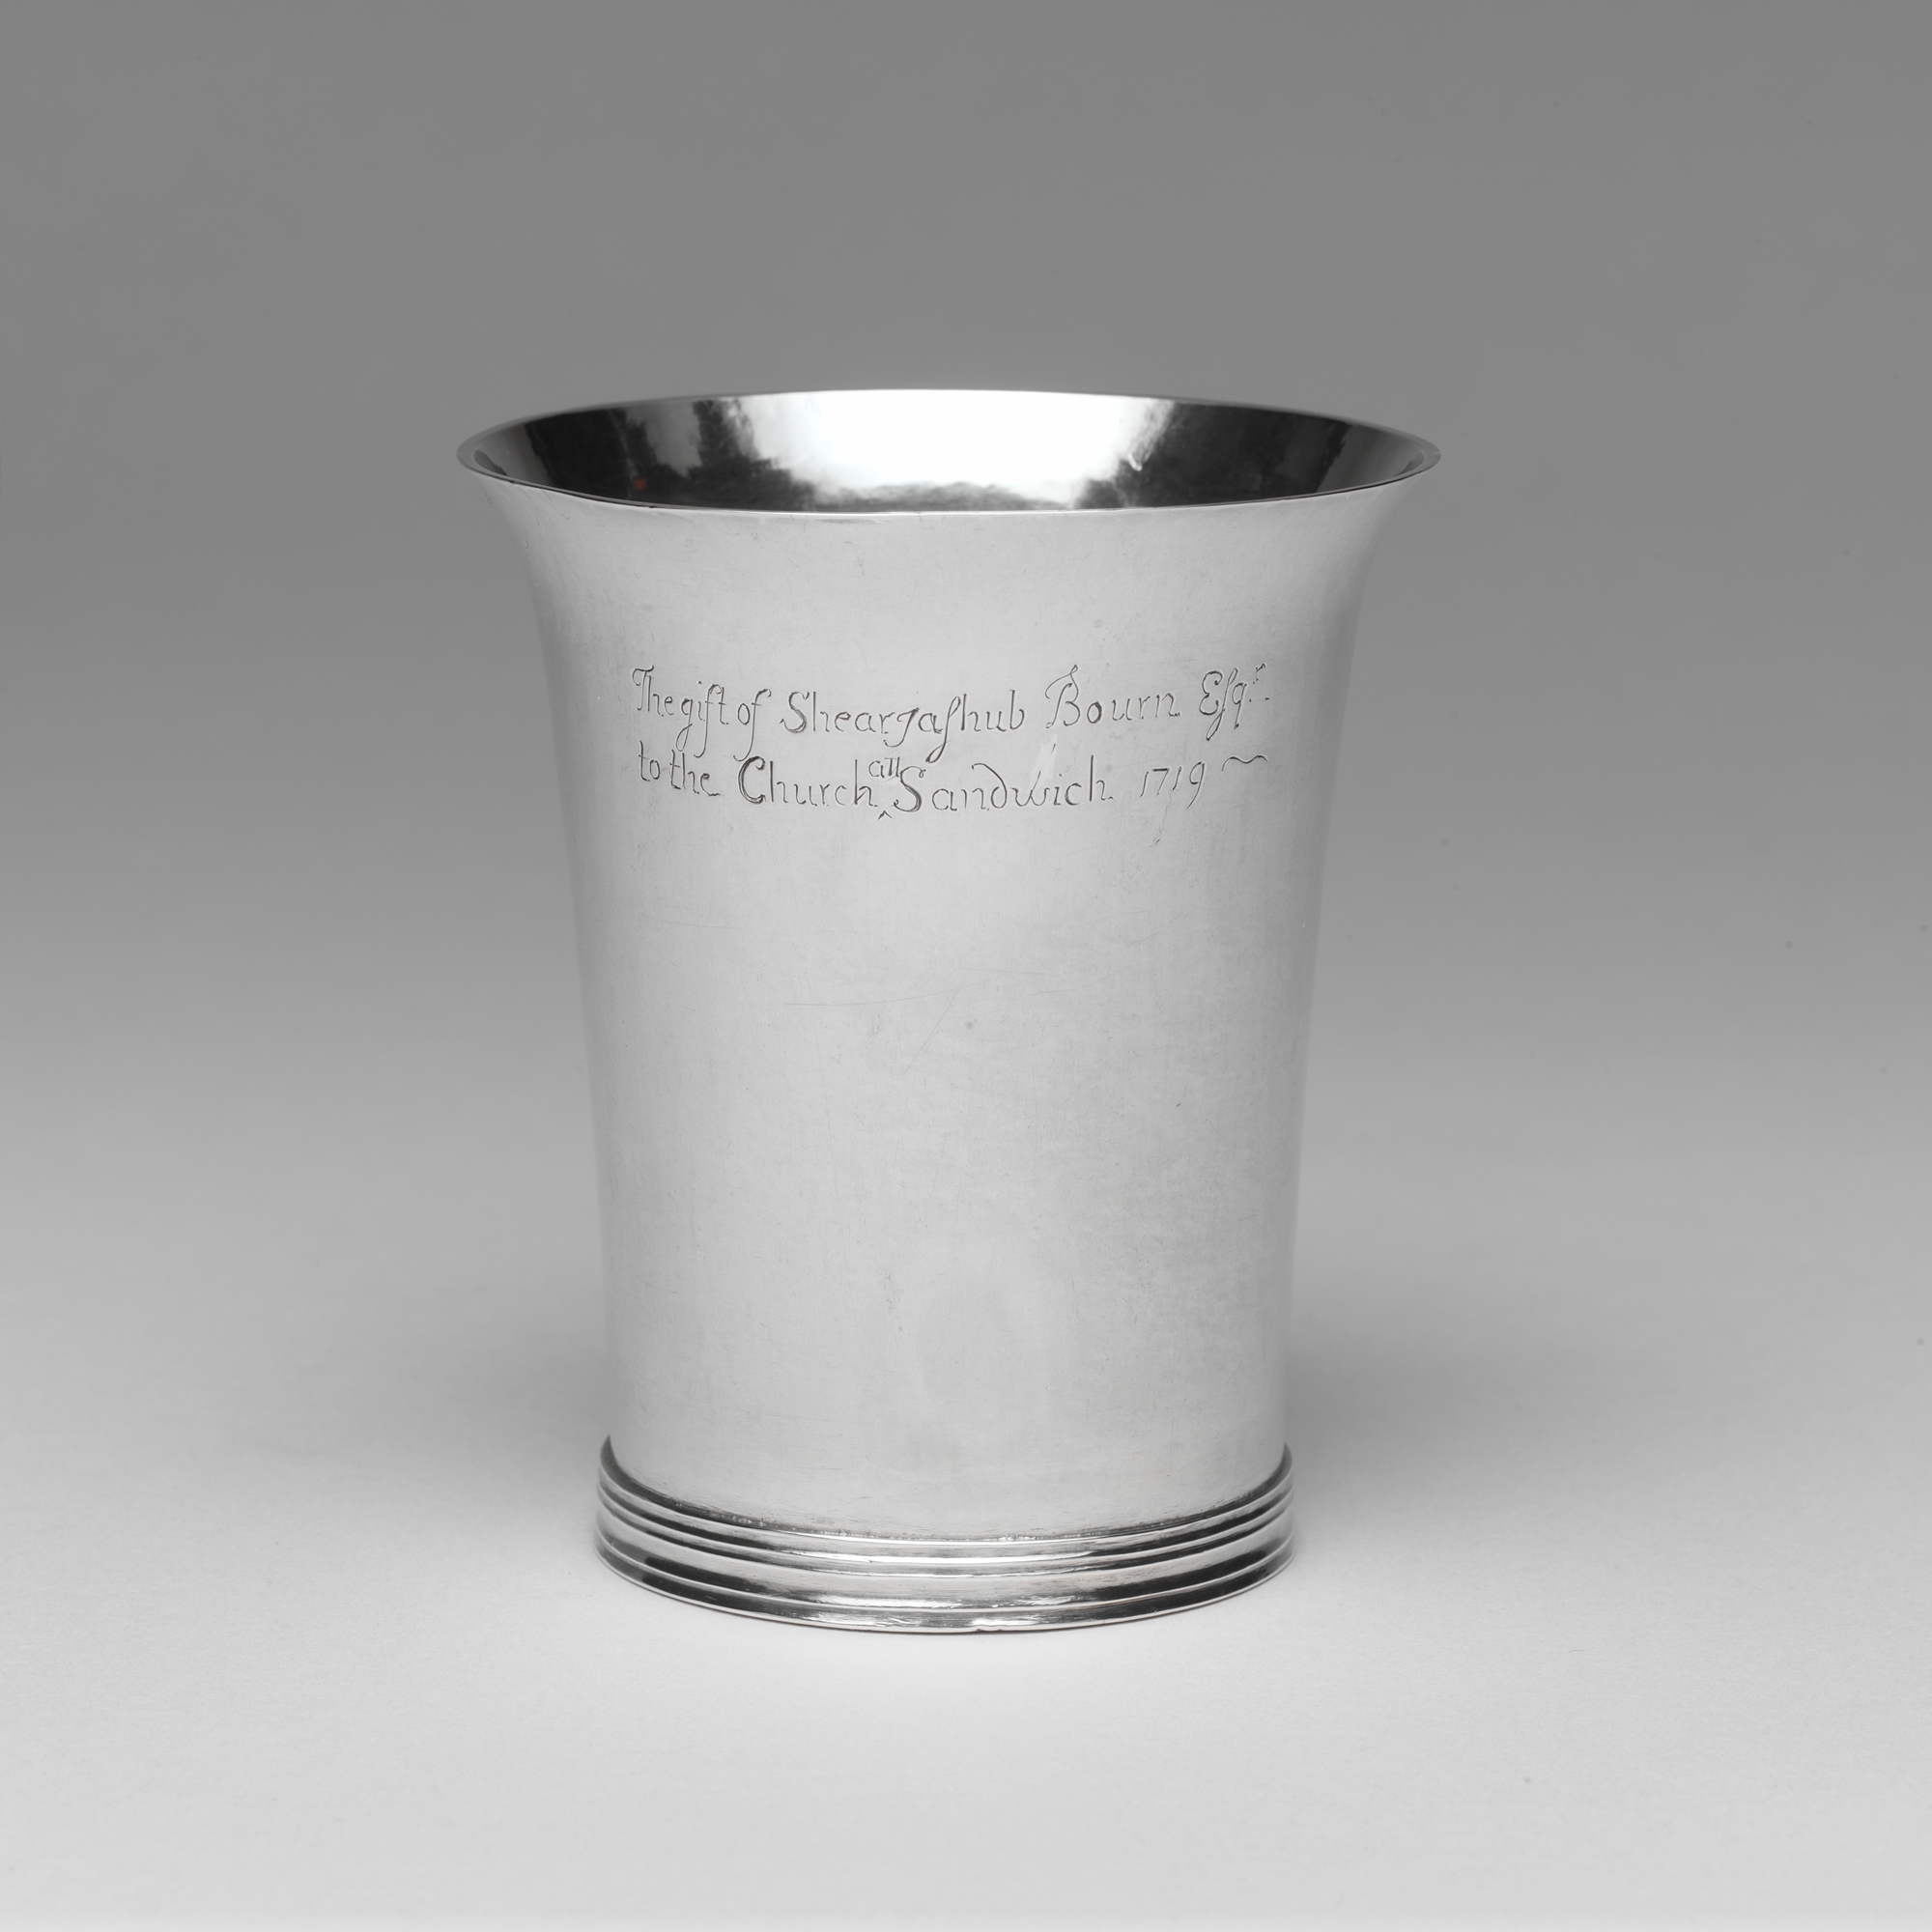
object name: beaker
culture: american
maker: moody russell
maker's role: maker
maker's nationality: american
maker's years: 1694-1761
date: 1719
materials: silver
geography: united states